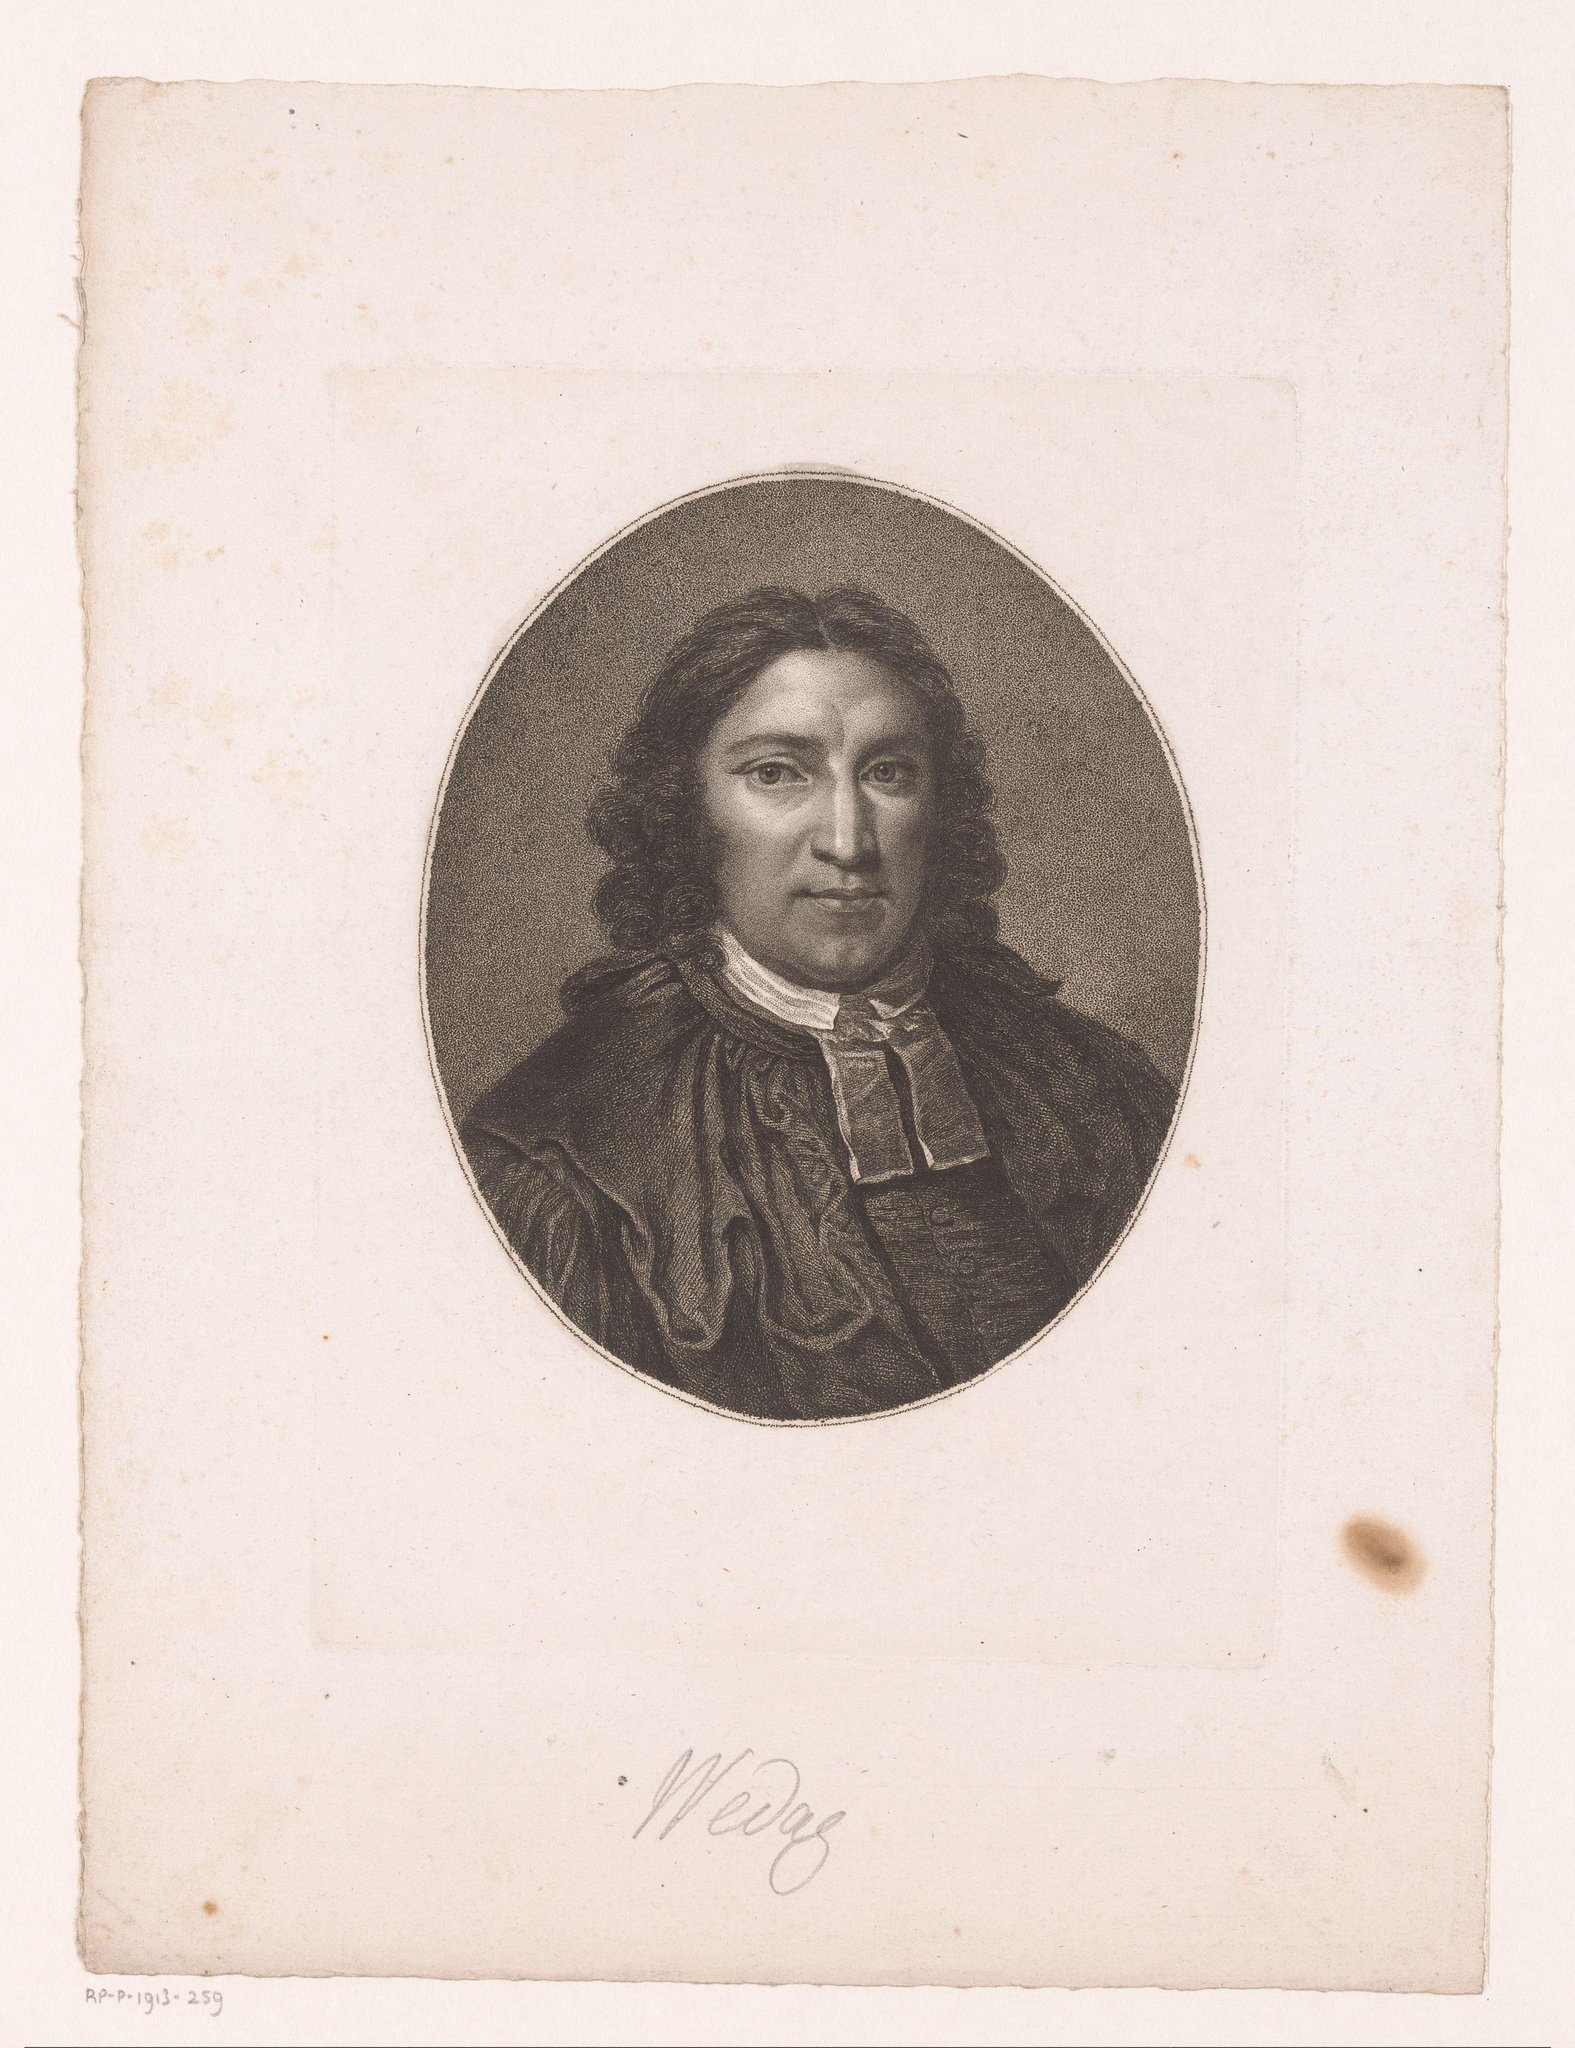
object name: print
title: Portret van Friedrich Wilhelm Wedag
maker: jacob mangot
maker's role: print maker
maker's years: 1701-1800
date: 1798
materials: paper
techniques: engraving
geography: germany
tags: historical persons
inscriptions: collector's mark: Lugt 2228